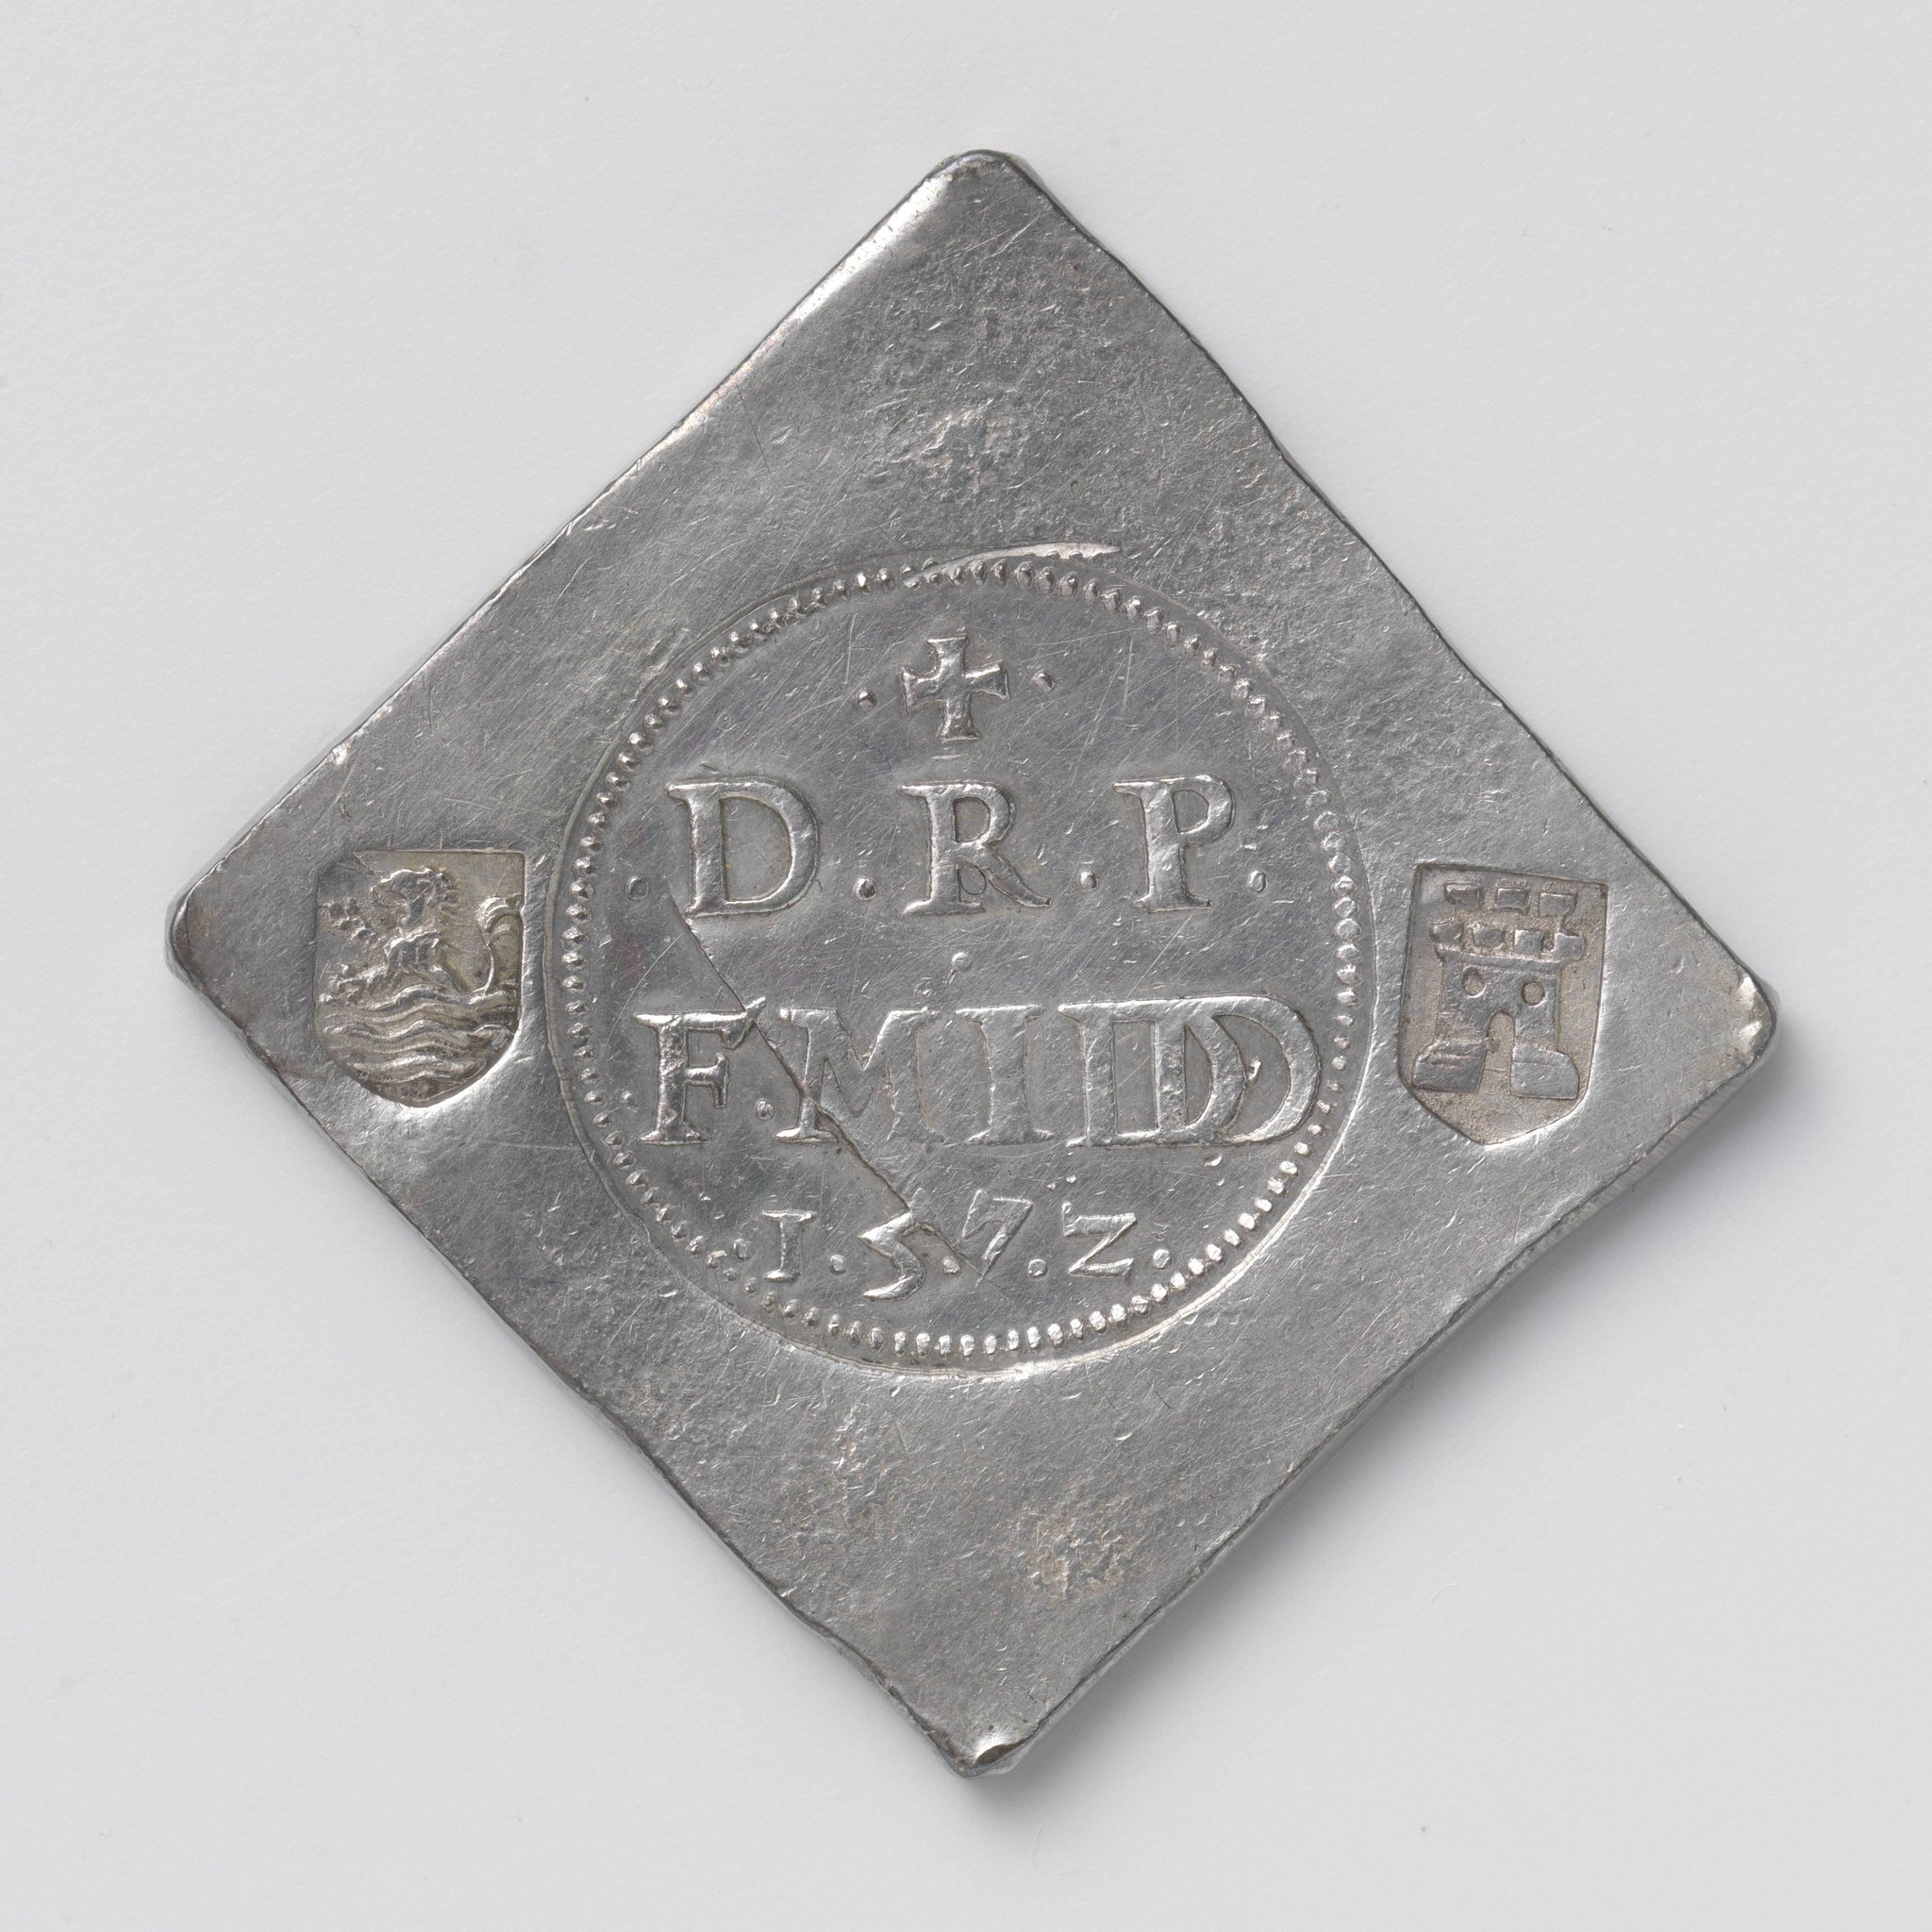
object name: thaler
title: Daalder, noodmunt uit Middelburg, geslagen tijdens het beleg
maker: Anonymous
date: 1572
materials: silver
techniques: striking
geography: middelburg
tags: middelburg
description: eenzijdige, ruitvormige noodmunt. Voorzijde: drie stempels: opschrift in ronde parelrand; links Staatswapen, rechts: stadswapen. Keerzijde: blanco